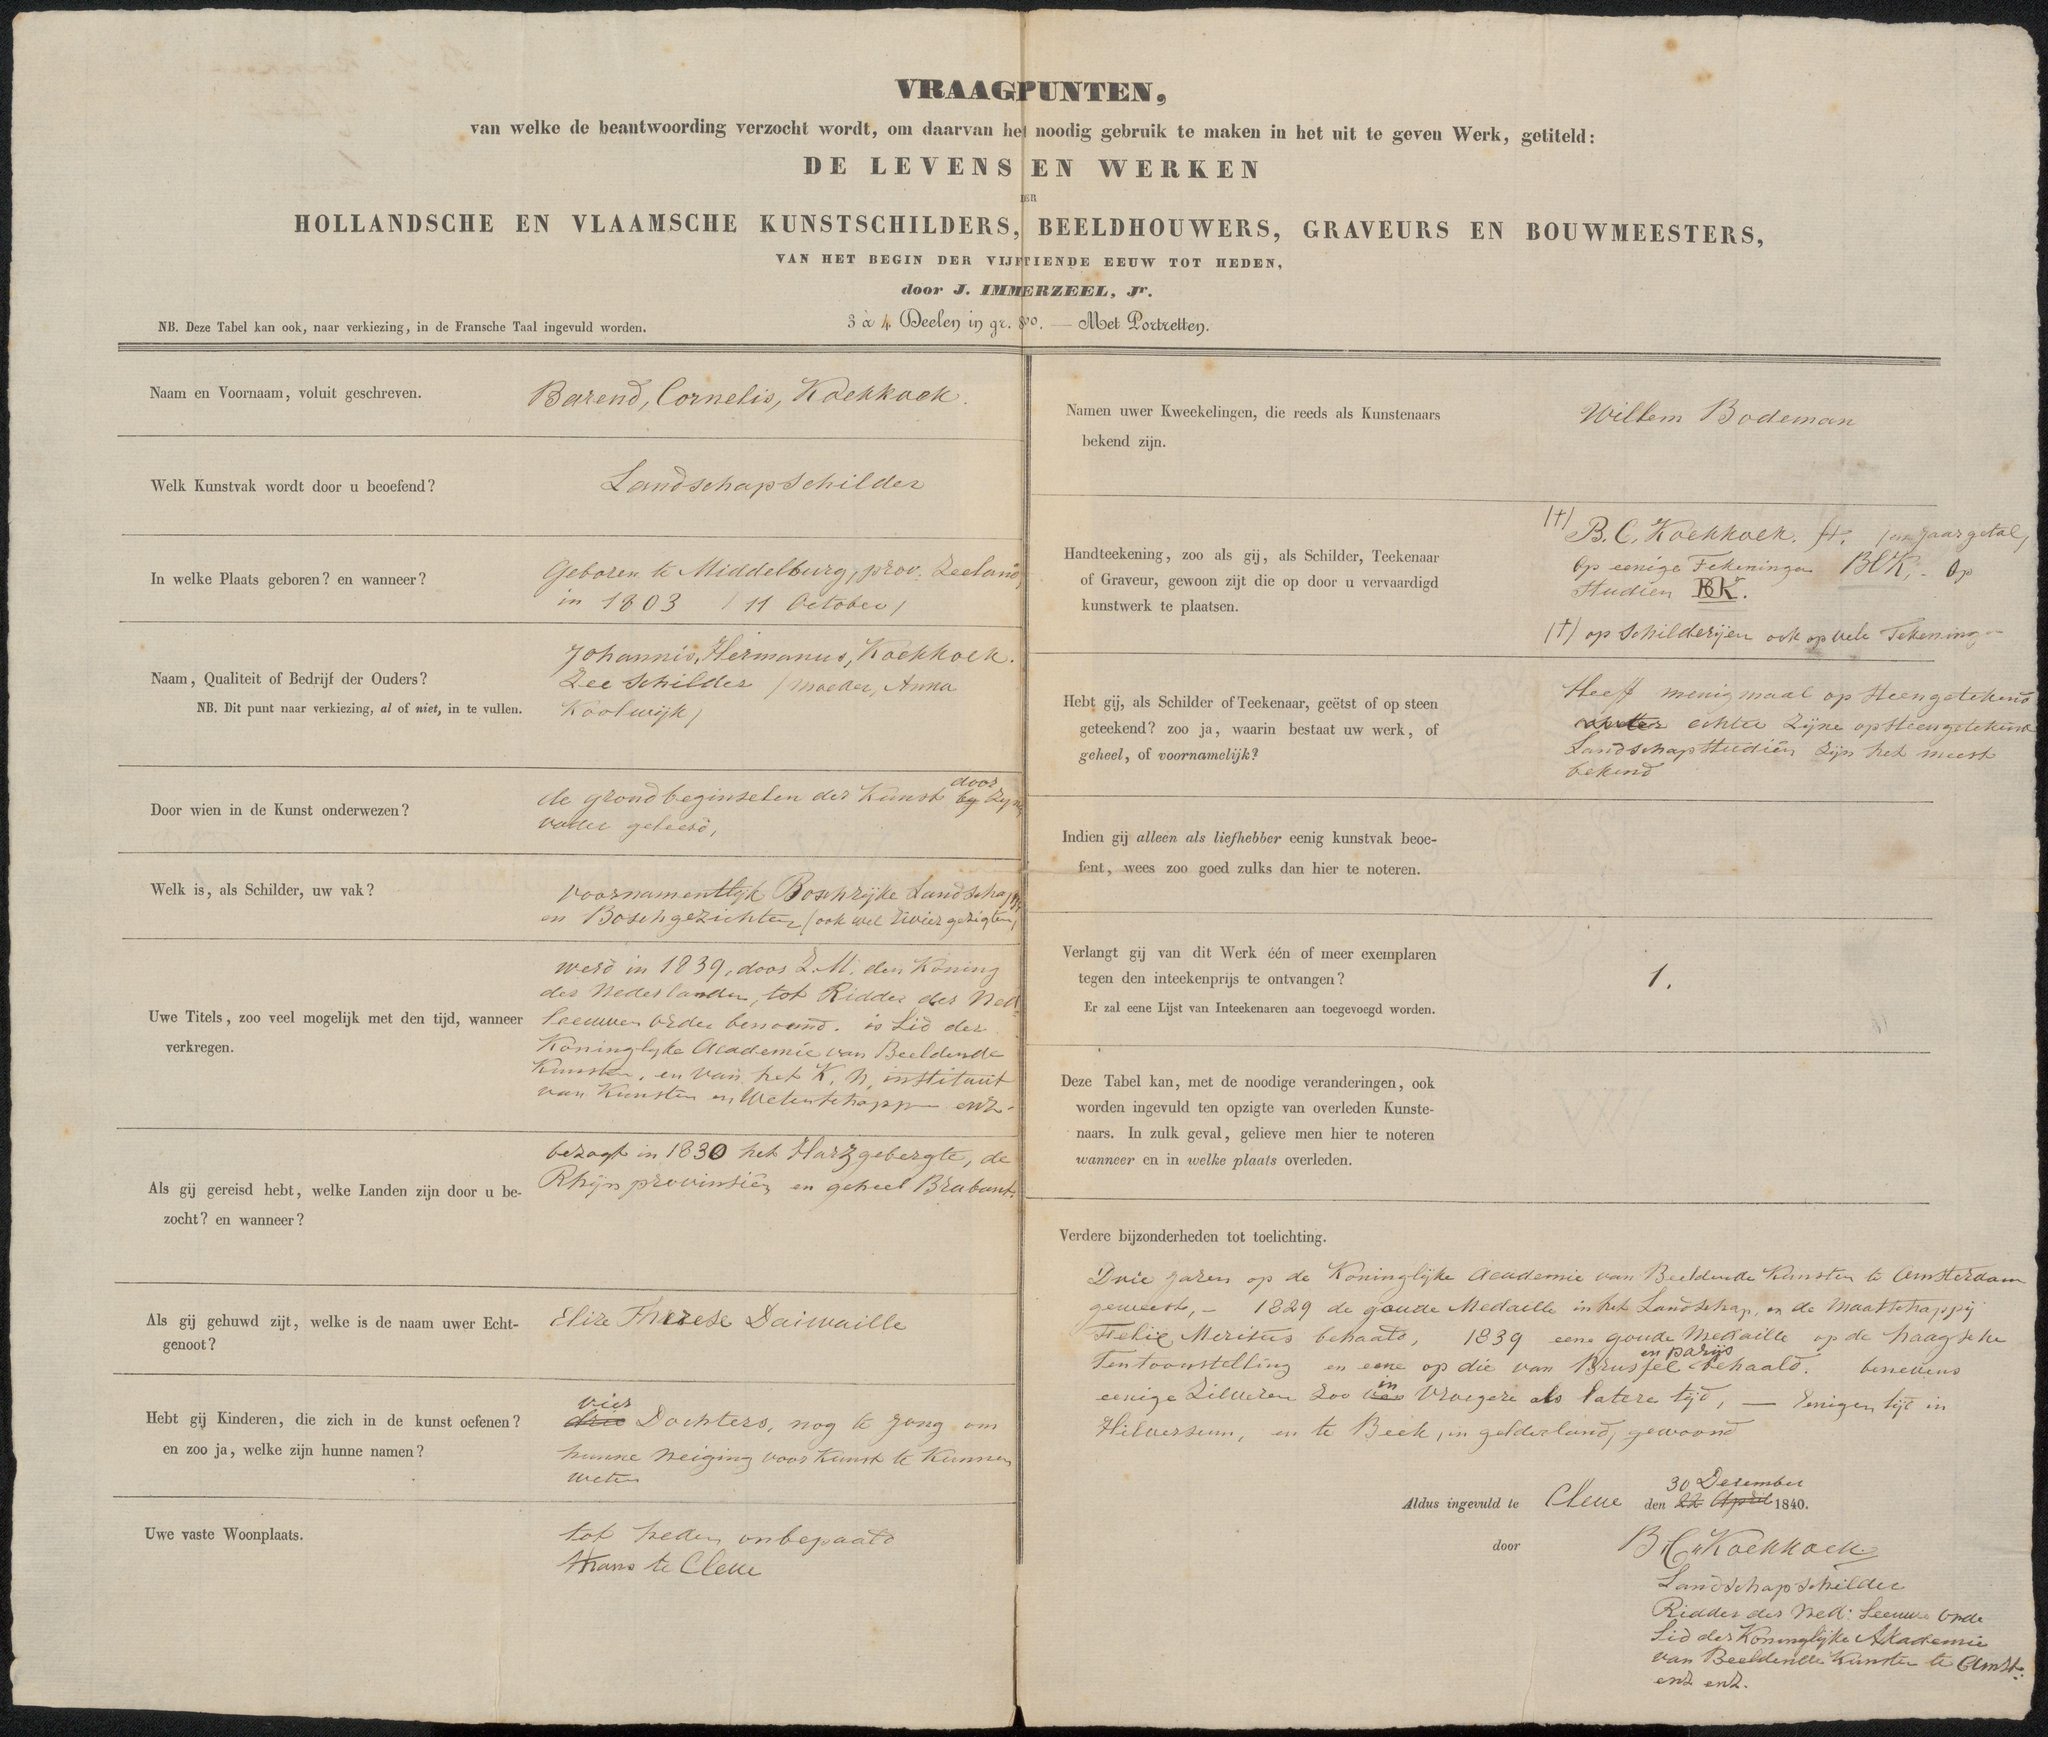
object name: manuscript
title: Enquêteformulier ingevuld door Barend Cornelis Koekkoek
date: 1840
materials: ink, paper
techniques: pen, printing, writing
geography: cleves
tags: middelburg, cleves, print maker, draughtsman, barend cornelis koekkoek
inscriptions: watermark, inscription: ‘Vraagpunten,/ van welke de beantwoording verzocht wordt, om daarvan het noodig gebruik te maken in het uit te geven Werk, getiteld: De levens en werken/ der Hollandsche en Vlaamsche kunstschilders, beeldhouwers,/ graveurs en bouwmeesters, van het begin der vijftiende eeuw tot heden/ door J. Immerzeel, Jr.’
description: Opgenomen in: Immerzeel, J. Jr., De levens en werken der Hollandsche en Vlaamsche kunstschilders, beeldhouwers, graveurs en bouwmeesters, van het begin der vijftiende eeuw tot heden, Amsterdam: J.C. van Kesteren, 1842-1843.